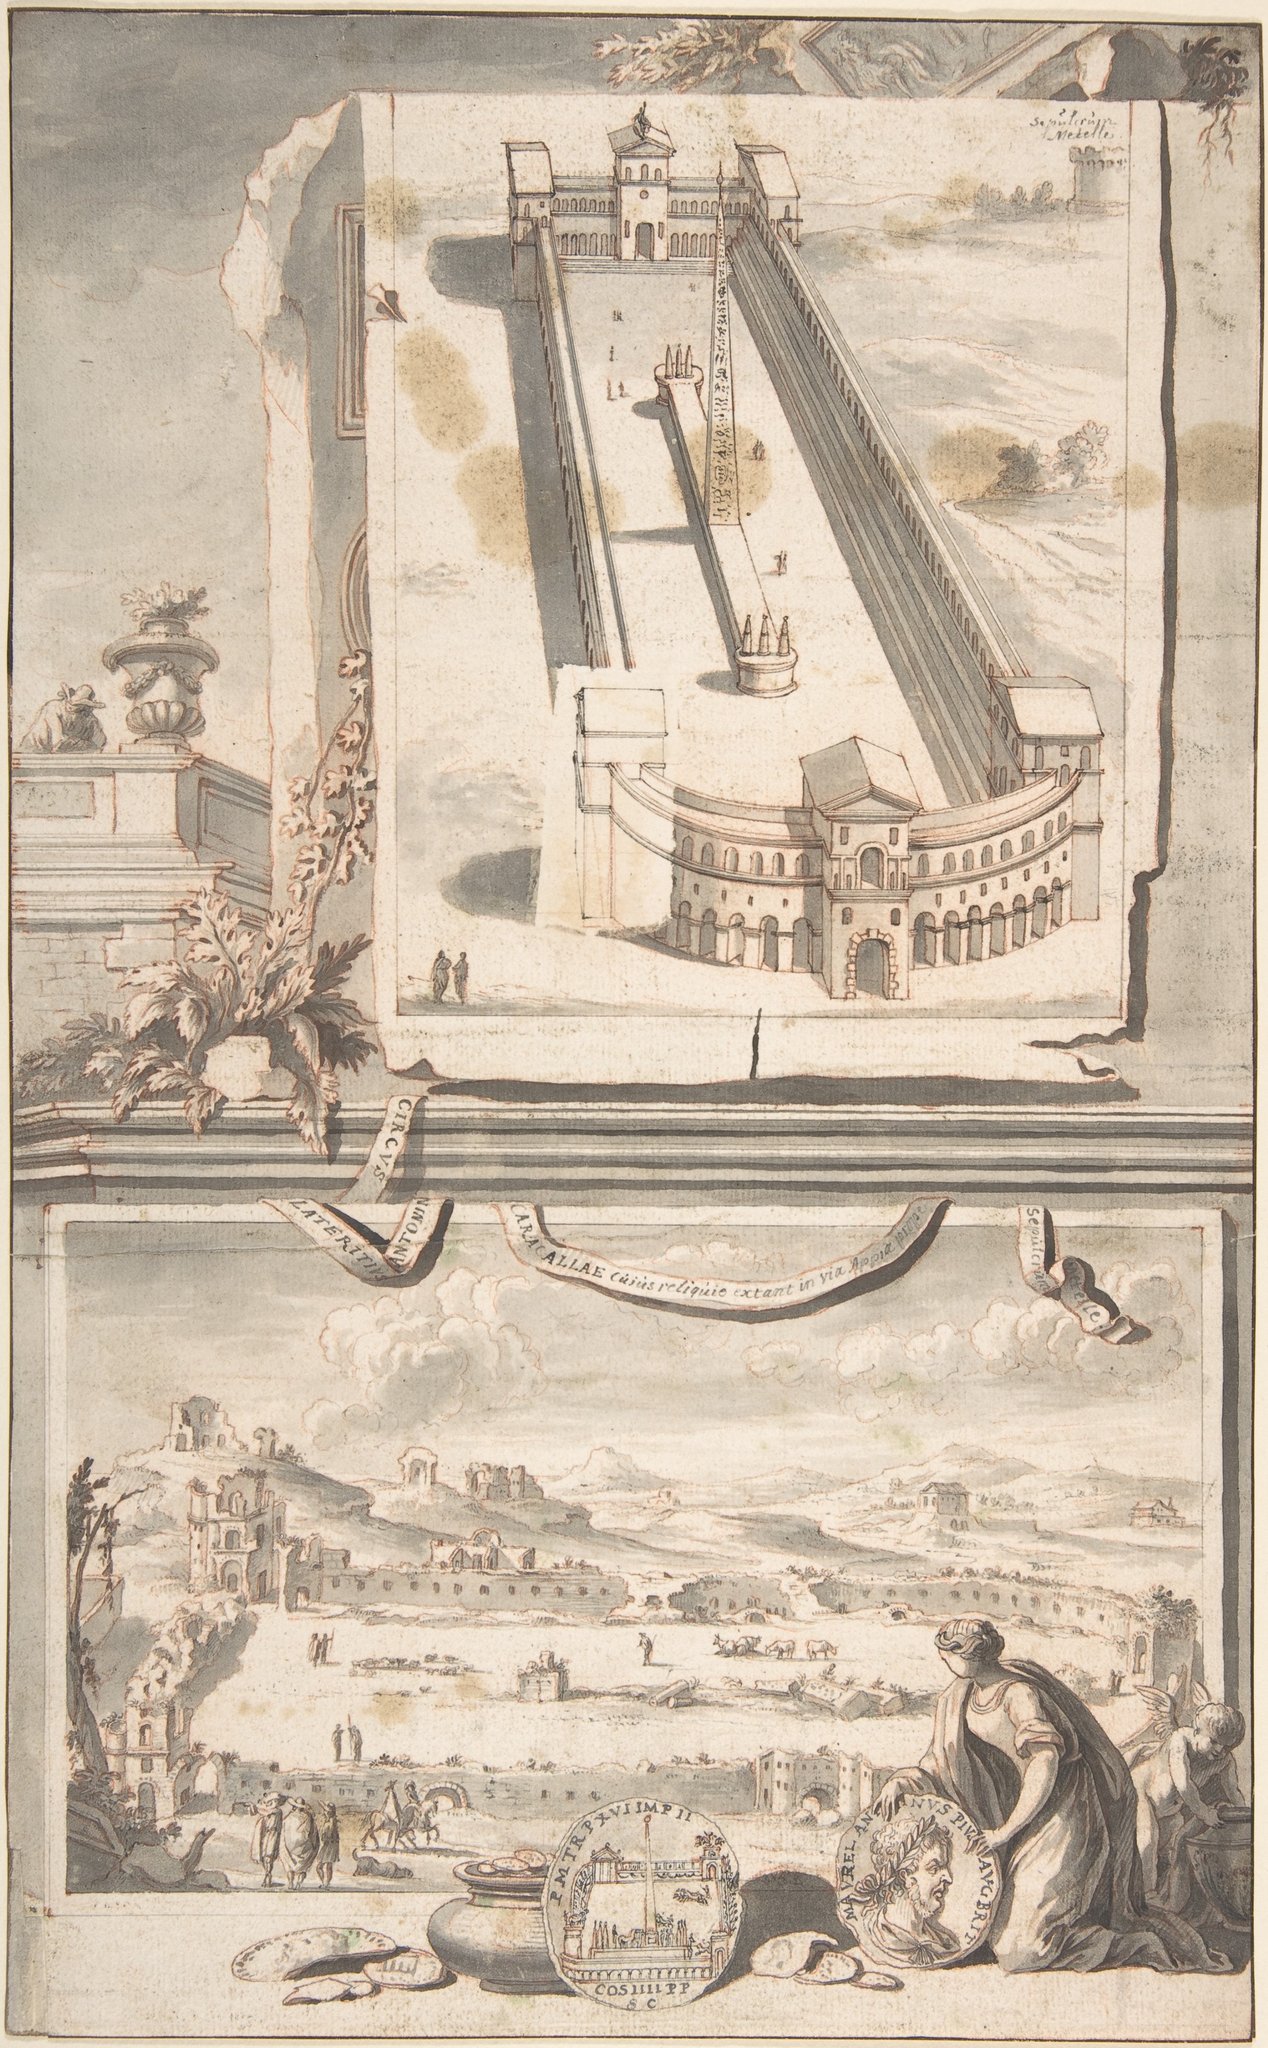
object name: drawing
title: Reconstruction of the Circus of Caracalla (above) and a View of the Ruins (below)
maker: jan goeree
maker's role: artist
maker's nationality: dutch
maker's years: 1670-1731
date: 1704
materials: chalk, ink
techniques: brush, pen, wash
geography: italy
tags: ruins,men,profiles,women,circus